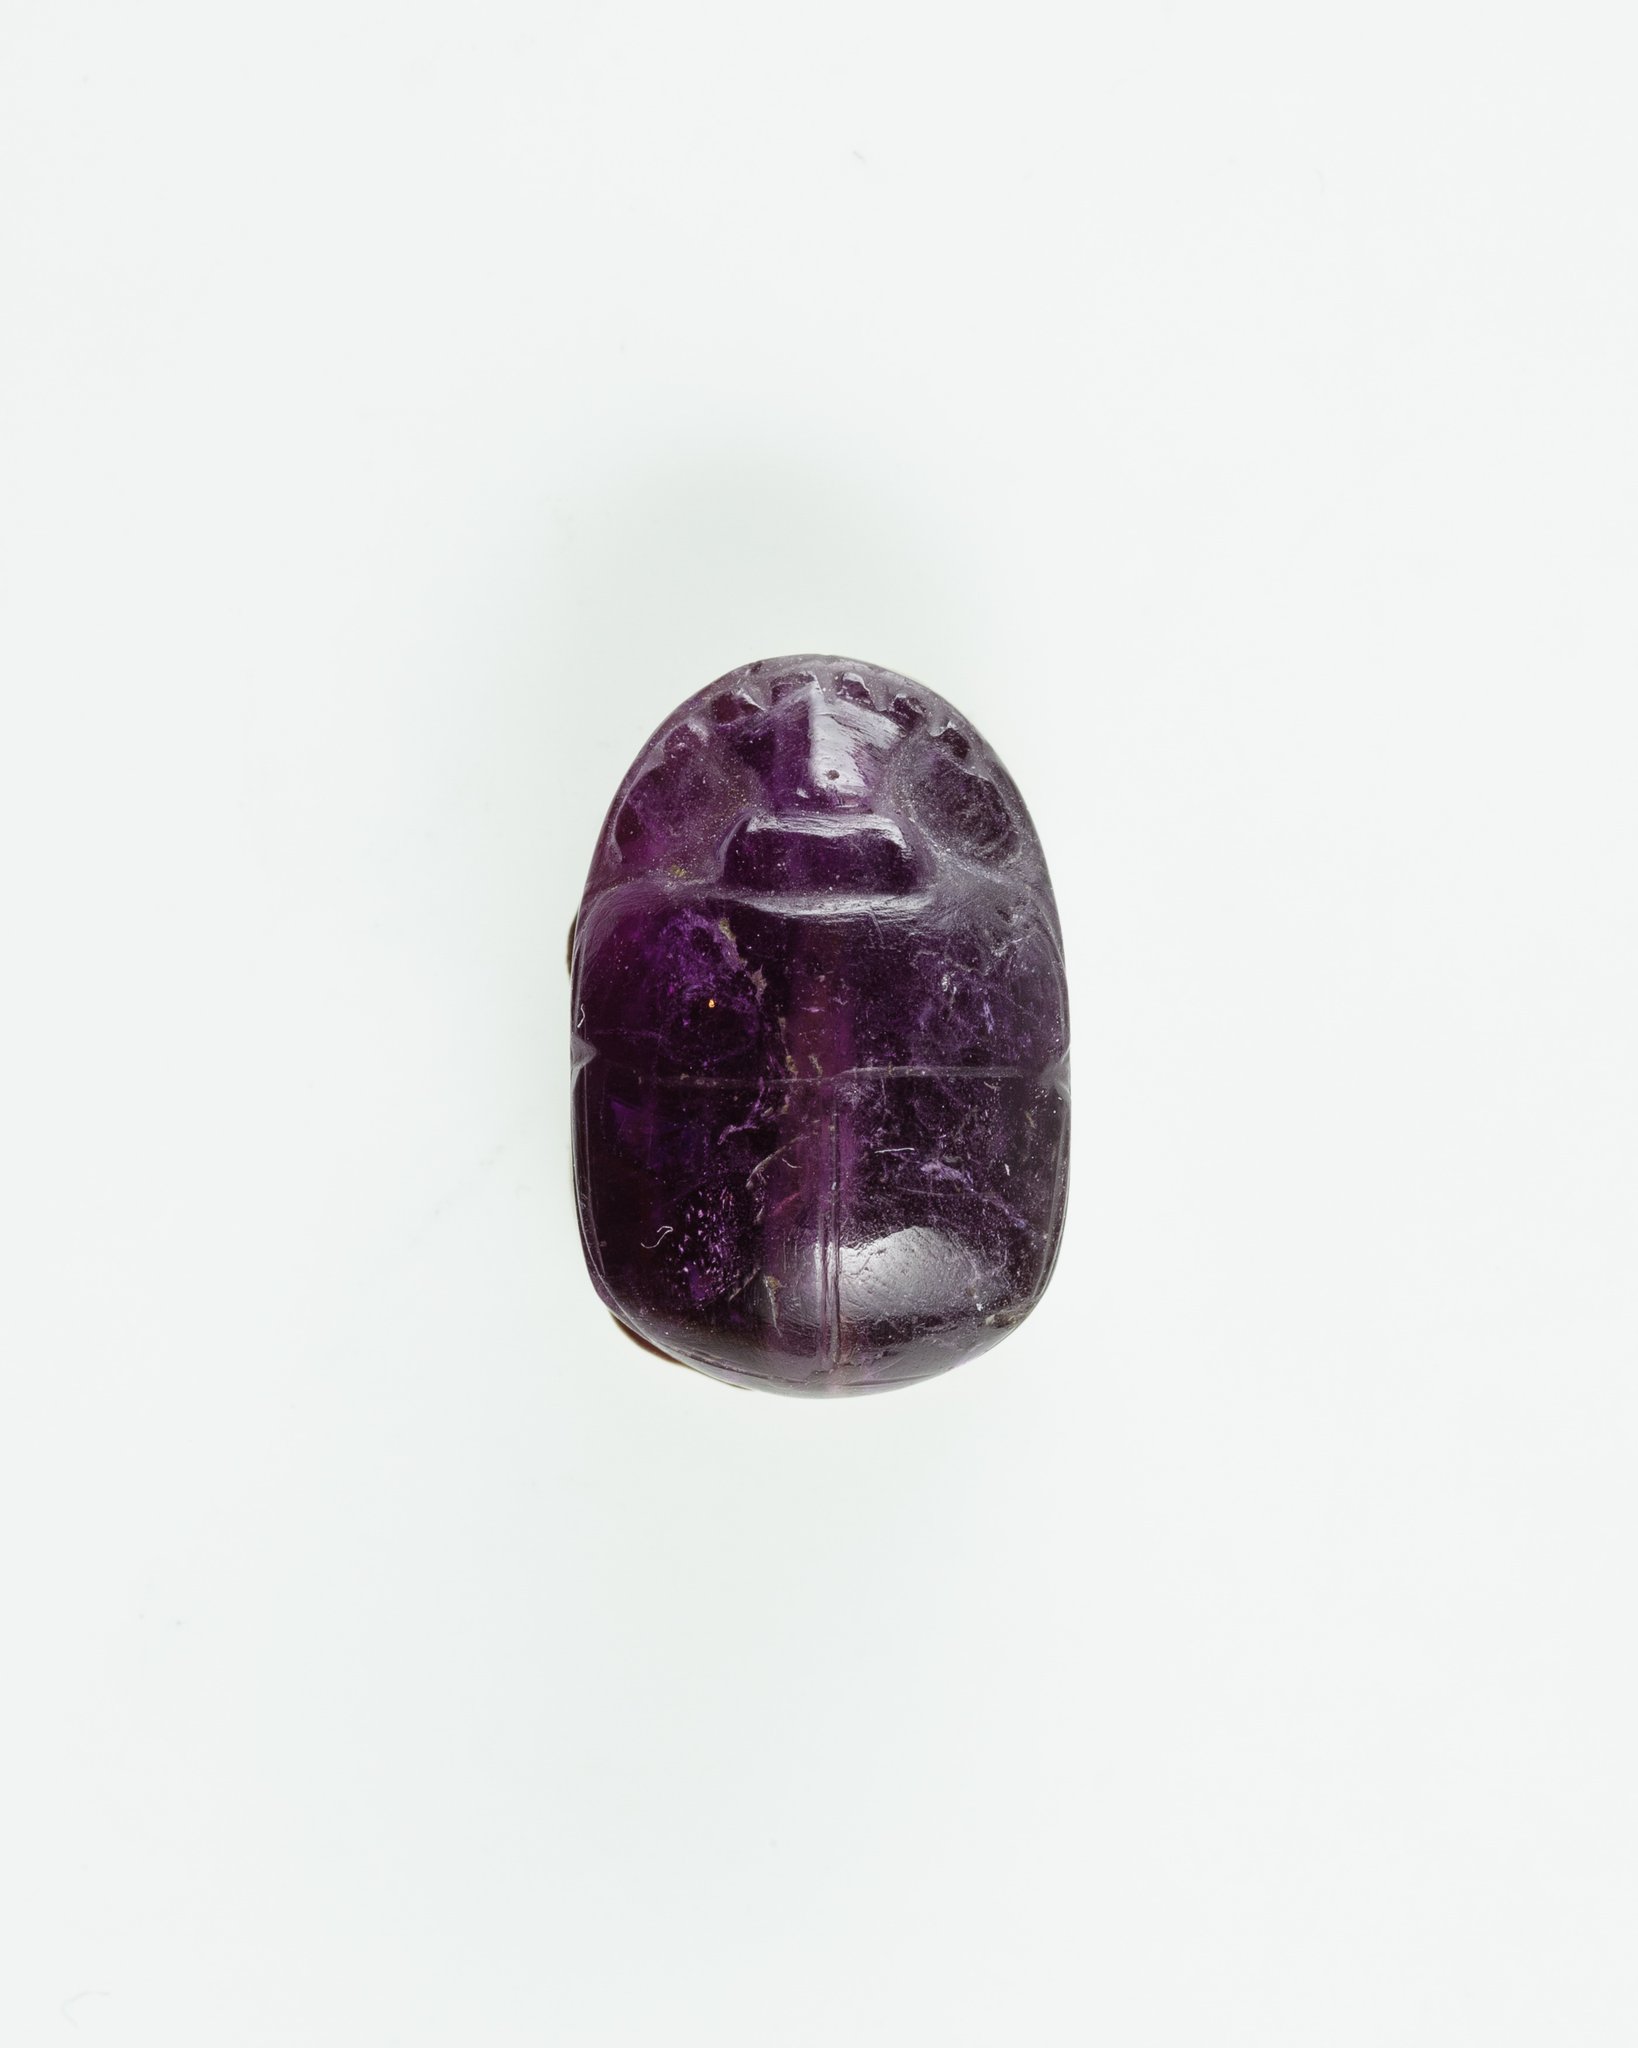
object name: scarab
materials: gemstone